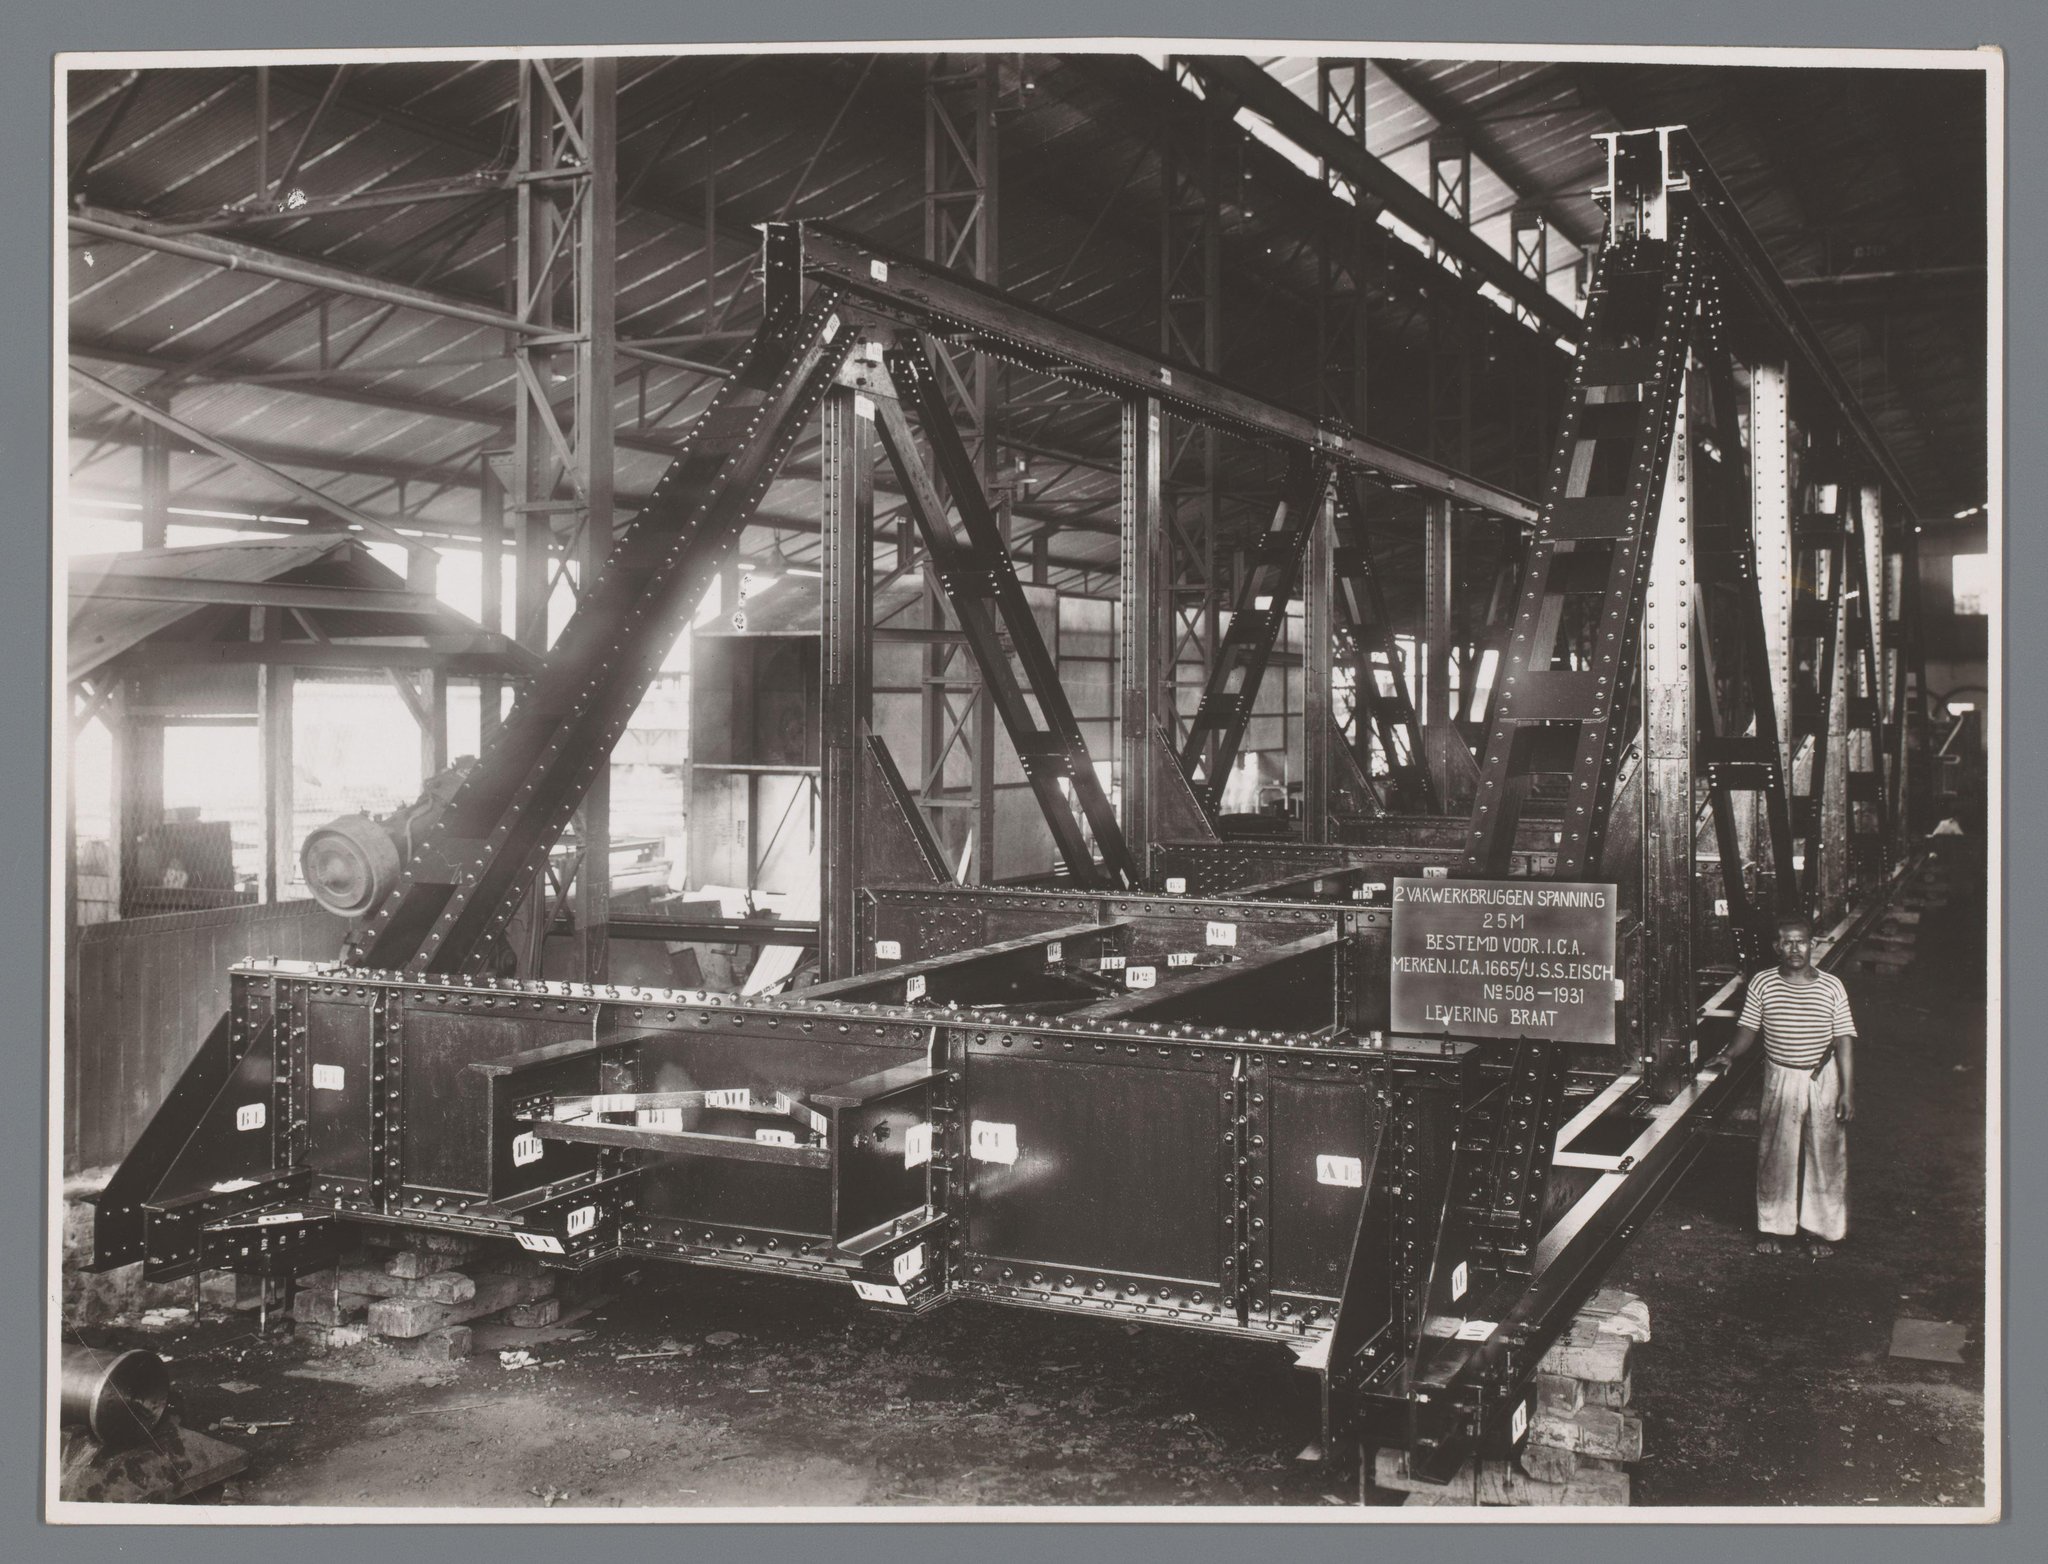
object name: photograph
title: Twee vakwerkbuggen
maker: Anonymous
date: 1931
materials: photographic support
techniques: gelatin silver print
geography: surabaya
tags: colonial system, factory-interior, machine shop, machines; parts of machines; tools and appliances, bridge, java, dutch east indies, the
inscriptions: date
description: Twee vakwerkbruggen vervaardigd in 1931 en bestemd voor de Indische Centrale Aanschaffingsdienst (I.C.A.). Onderdeel van de multomap met foto's van bruggen gebouwd door de N.V. Machinefabriek Braat te Soerabaja en bestemd voor verschillende plaatsen in Nederlands-Indië, uit de periode 1931-1940.